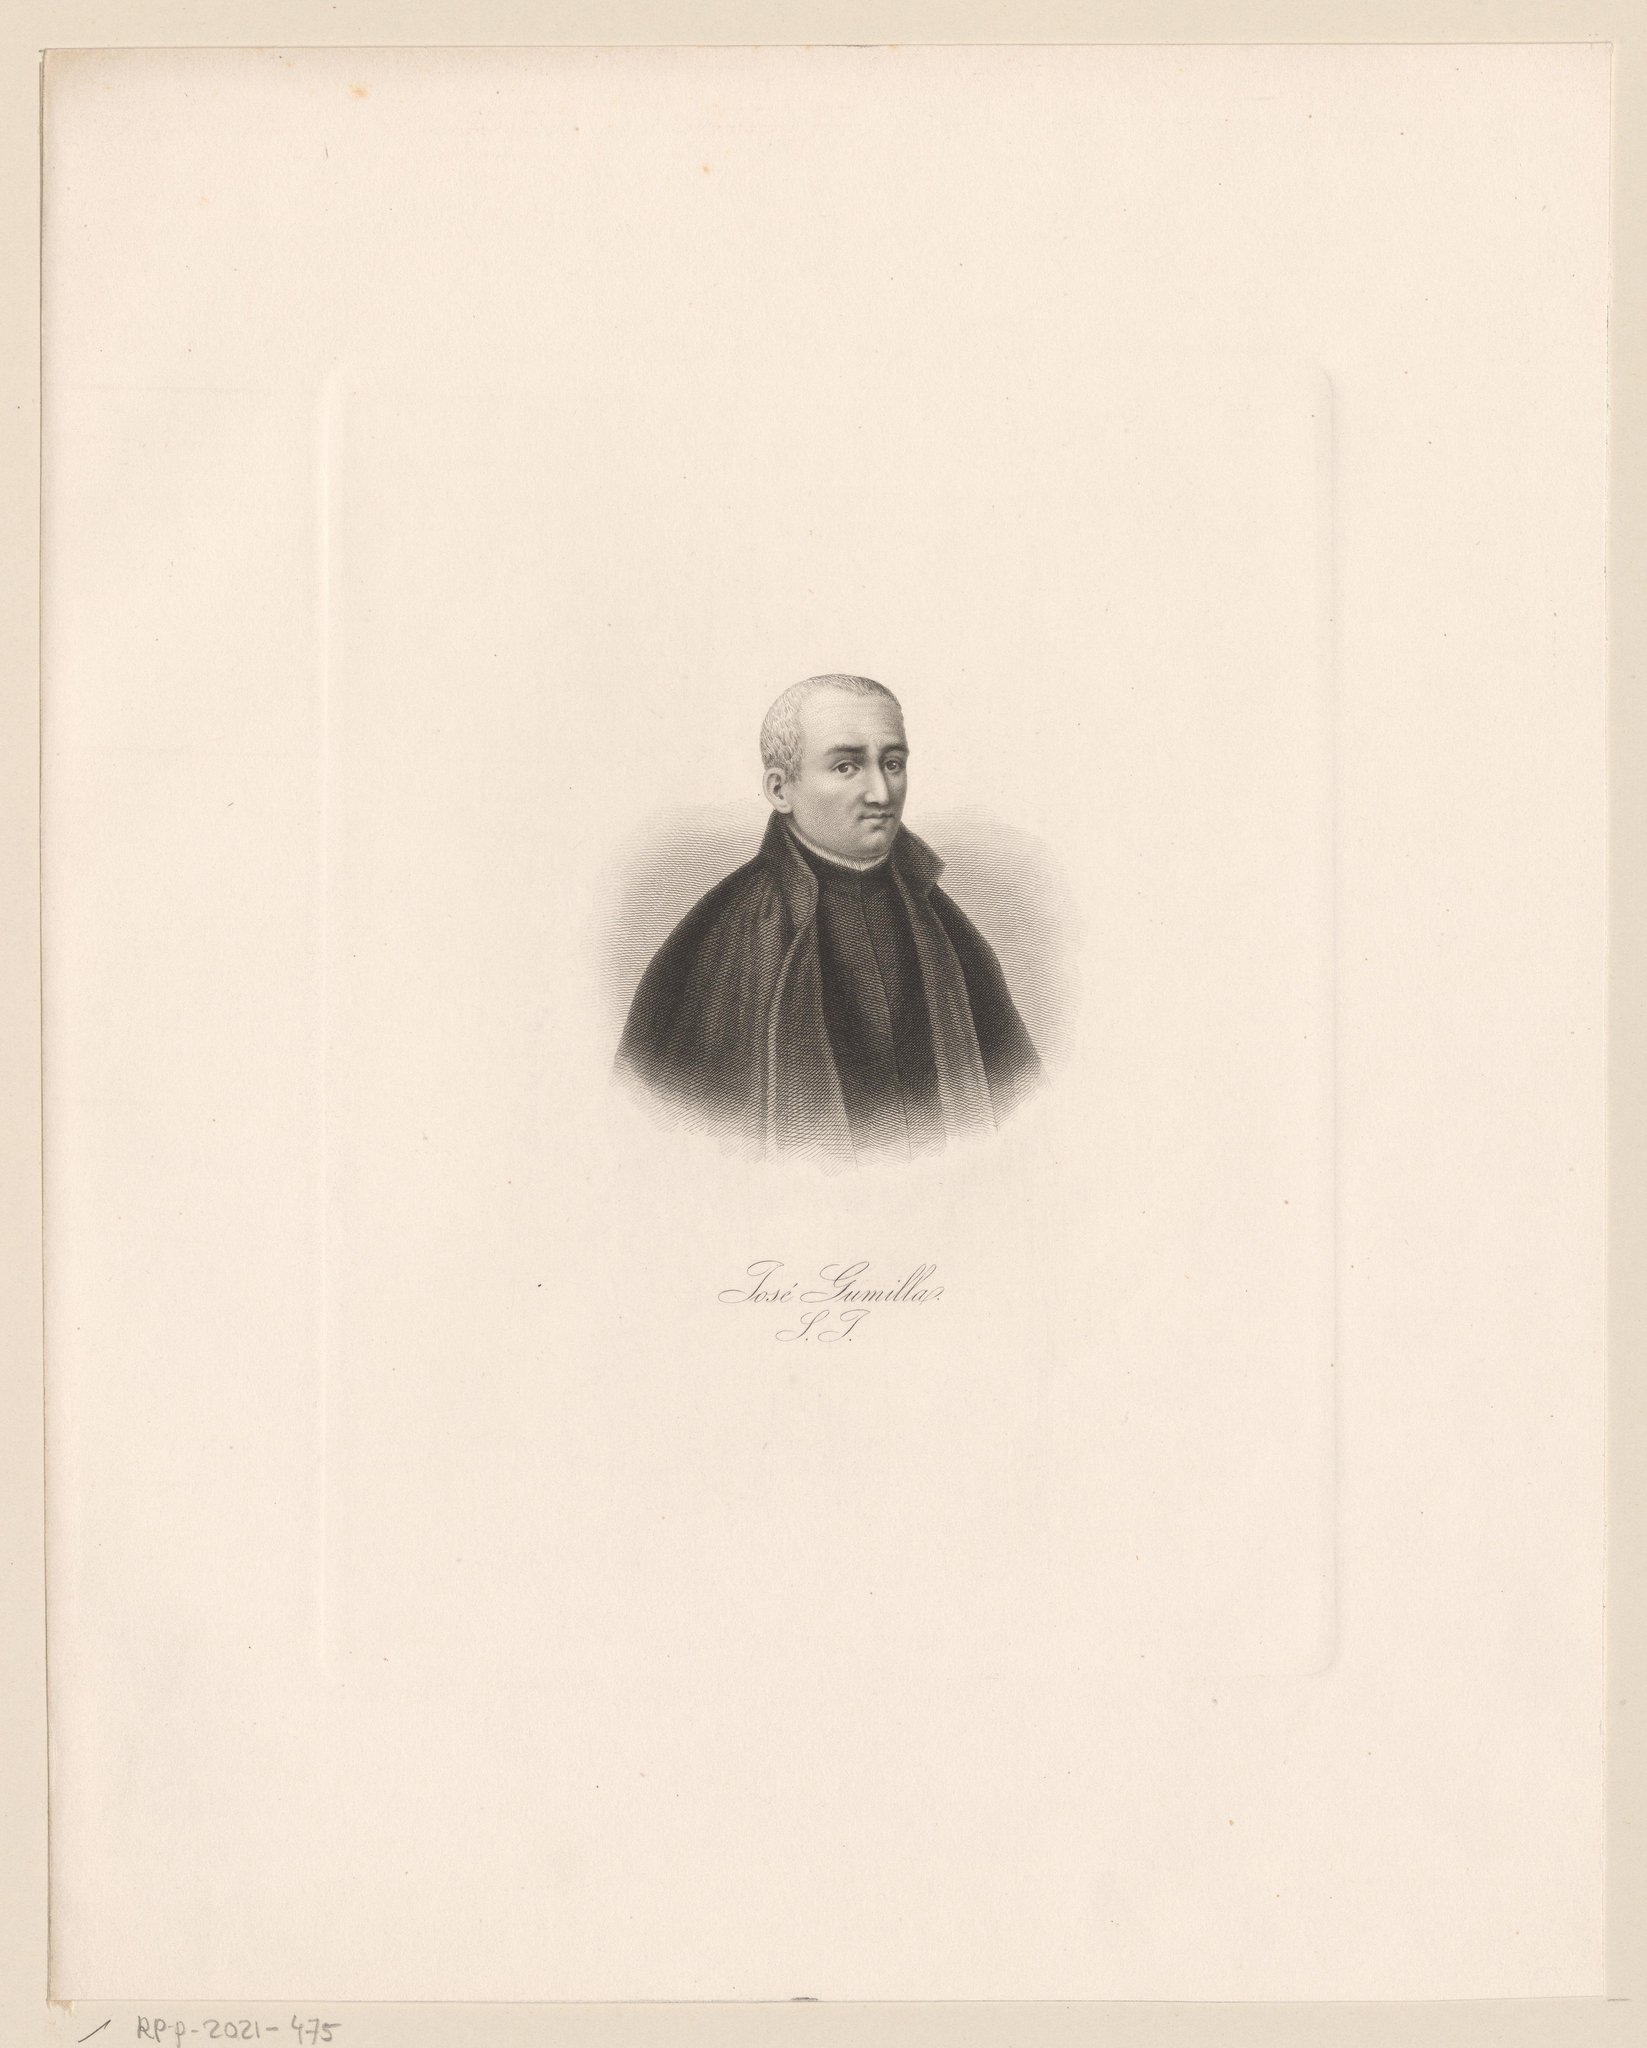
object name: print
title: Portret van Joseph Gumilla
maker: Anonymous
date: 1730-1830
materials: paper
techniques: engraving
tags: theologian, portrait of a writer, literary characters and objects